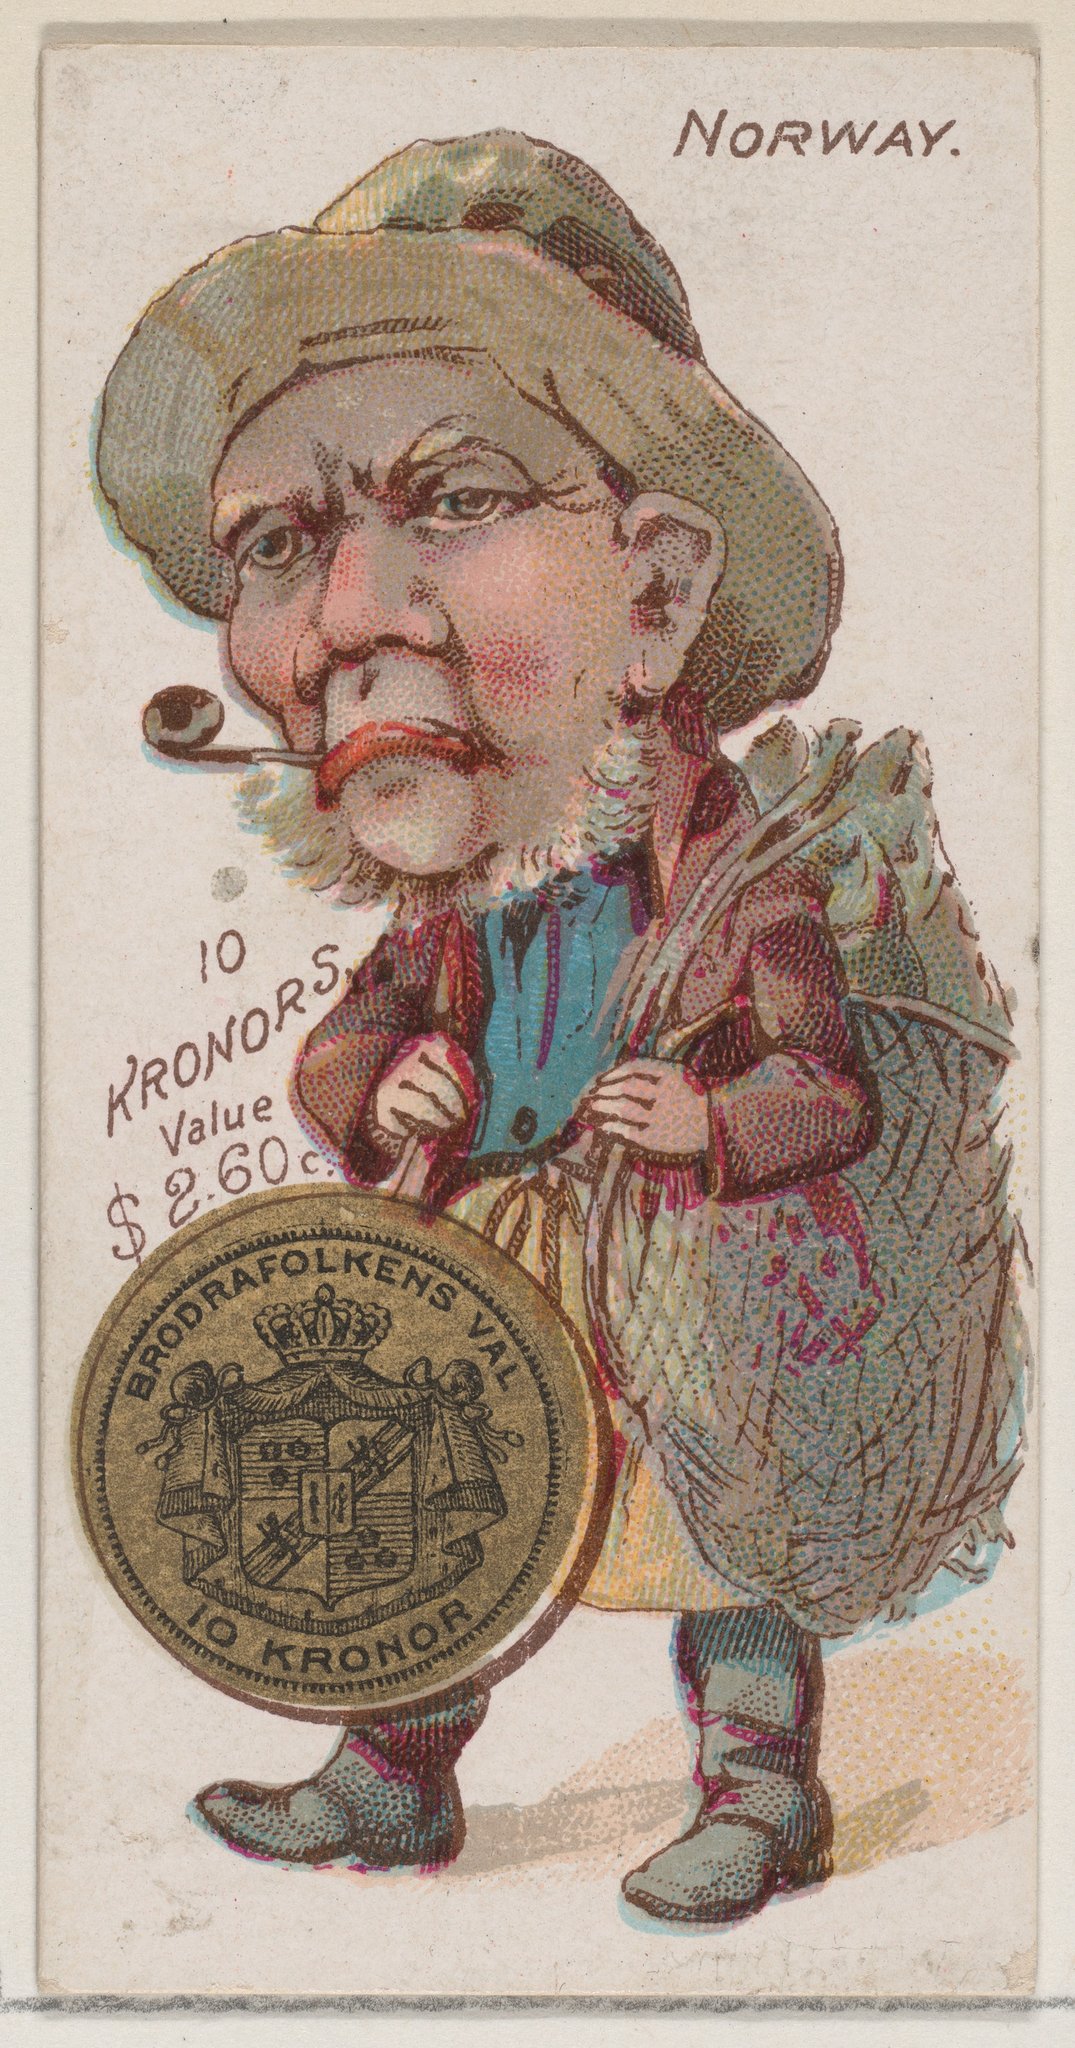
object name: print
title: Norway, 10 Kronors, from the series Coins of All Nations (N72, variation 1) for Duke brand cigarettes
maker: w. duke, sons & co.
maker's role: publisher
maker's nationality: american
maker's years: 1870-1920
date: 1889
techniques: color lithograph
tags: men,smoking,coins